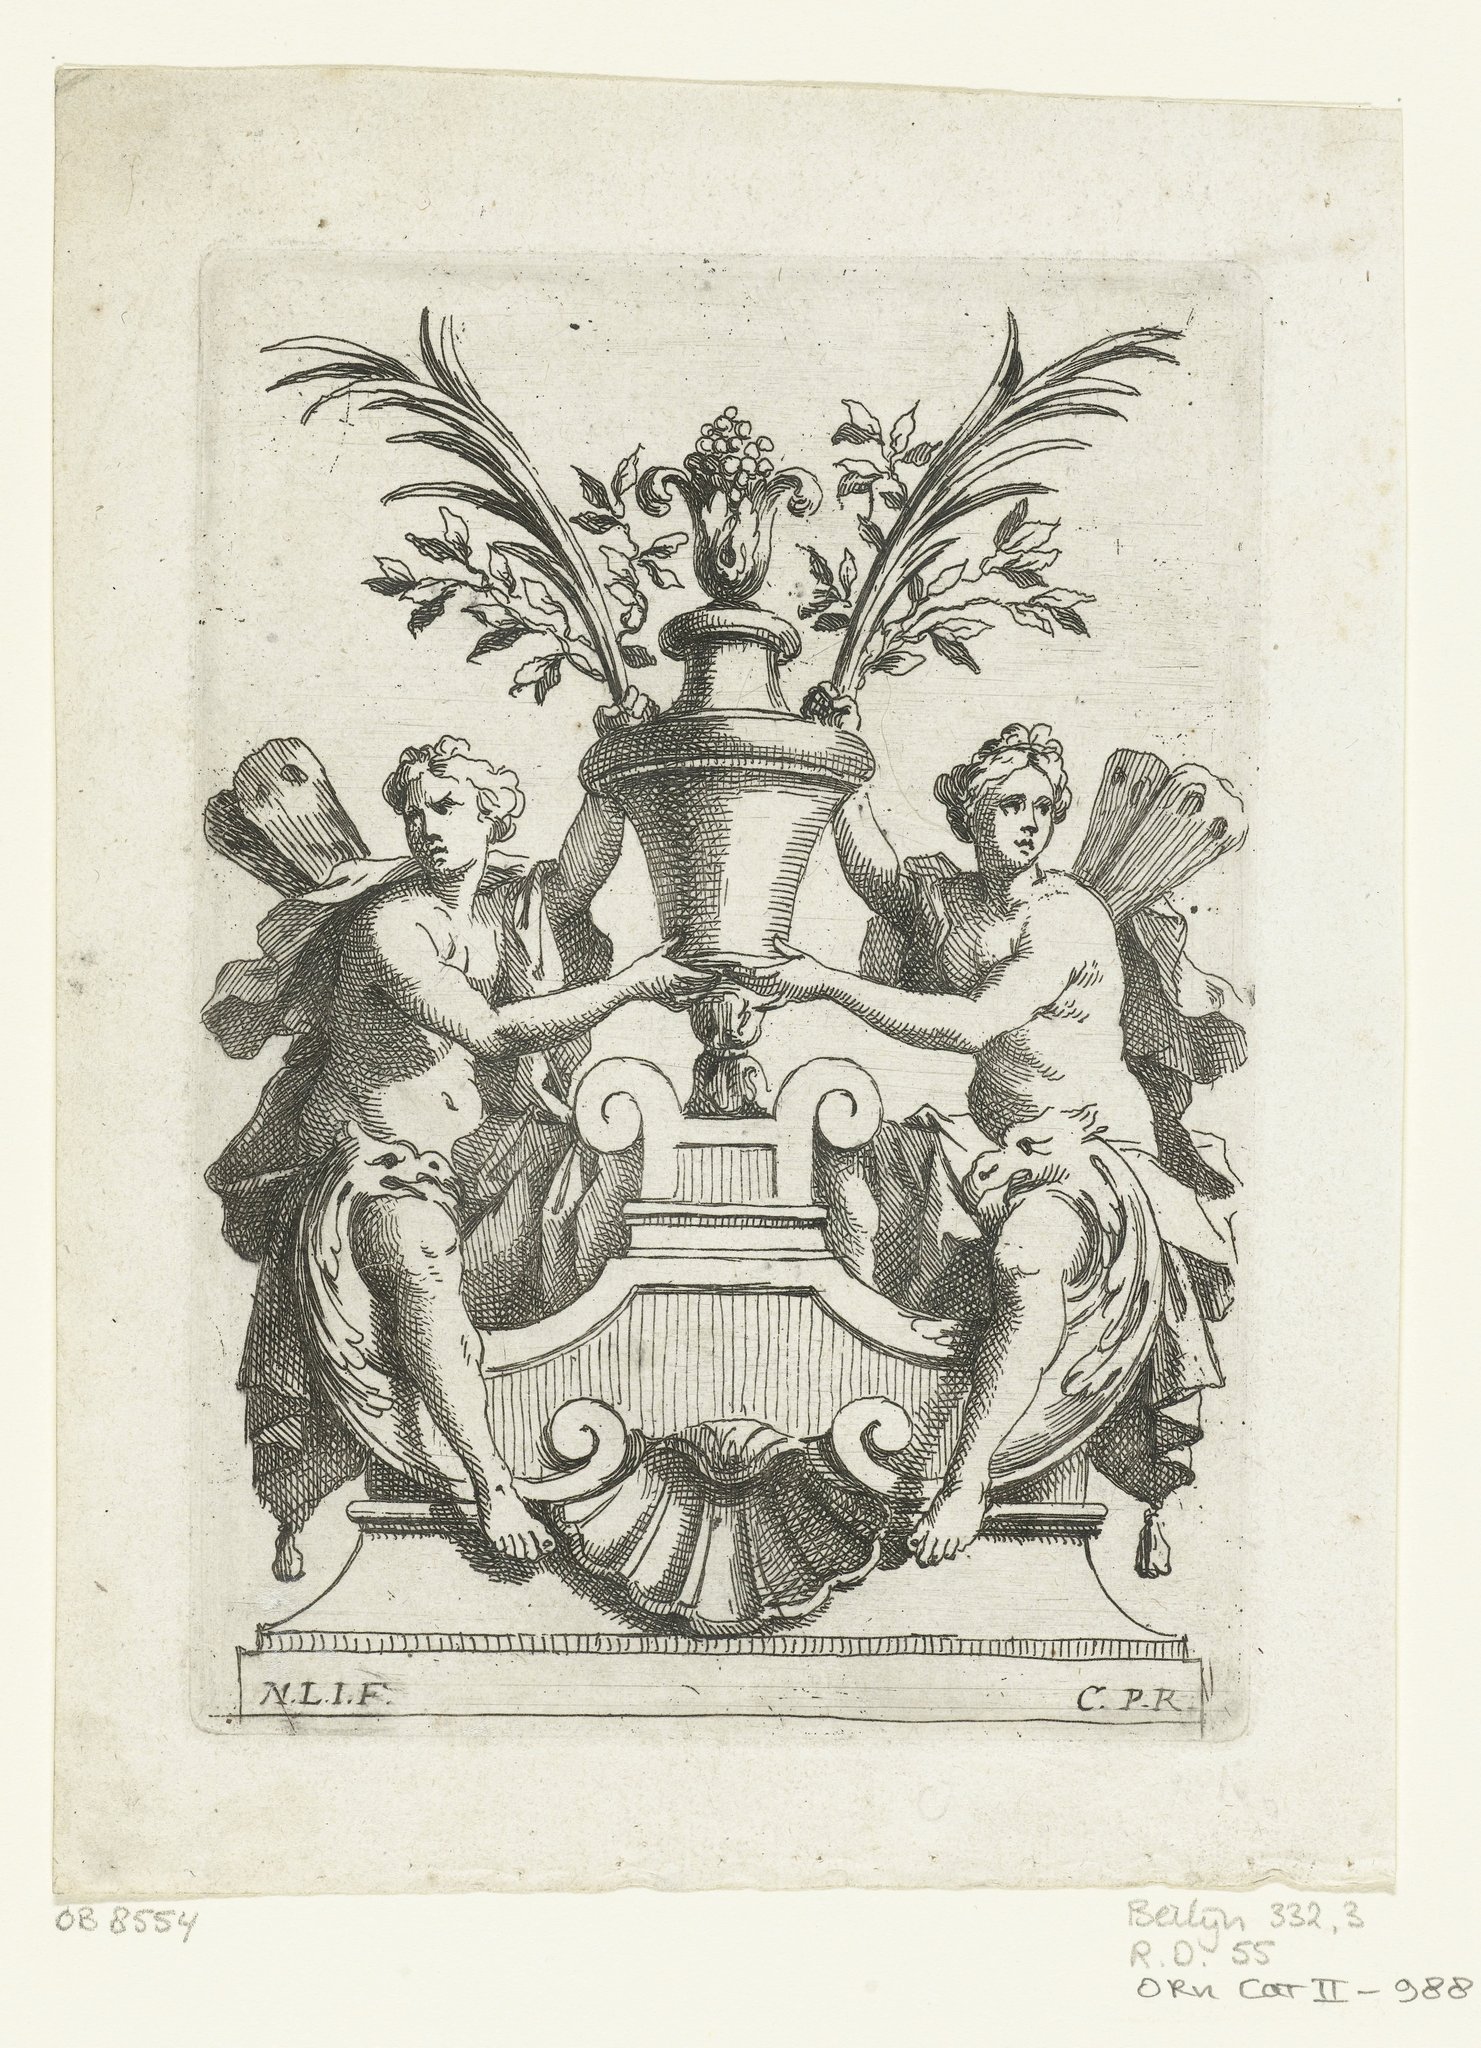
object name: ornament print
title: Divers Ornemens, Trophées et Panneaux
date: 1660-1670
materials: paper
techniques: etching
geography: france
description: De nimfen hebben beide een palmtak in de hand. Blad 10 uit serie van 12.